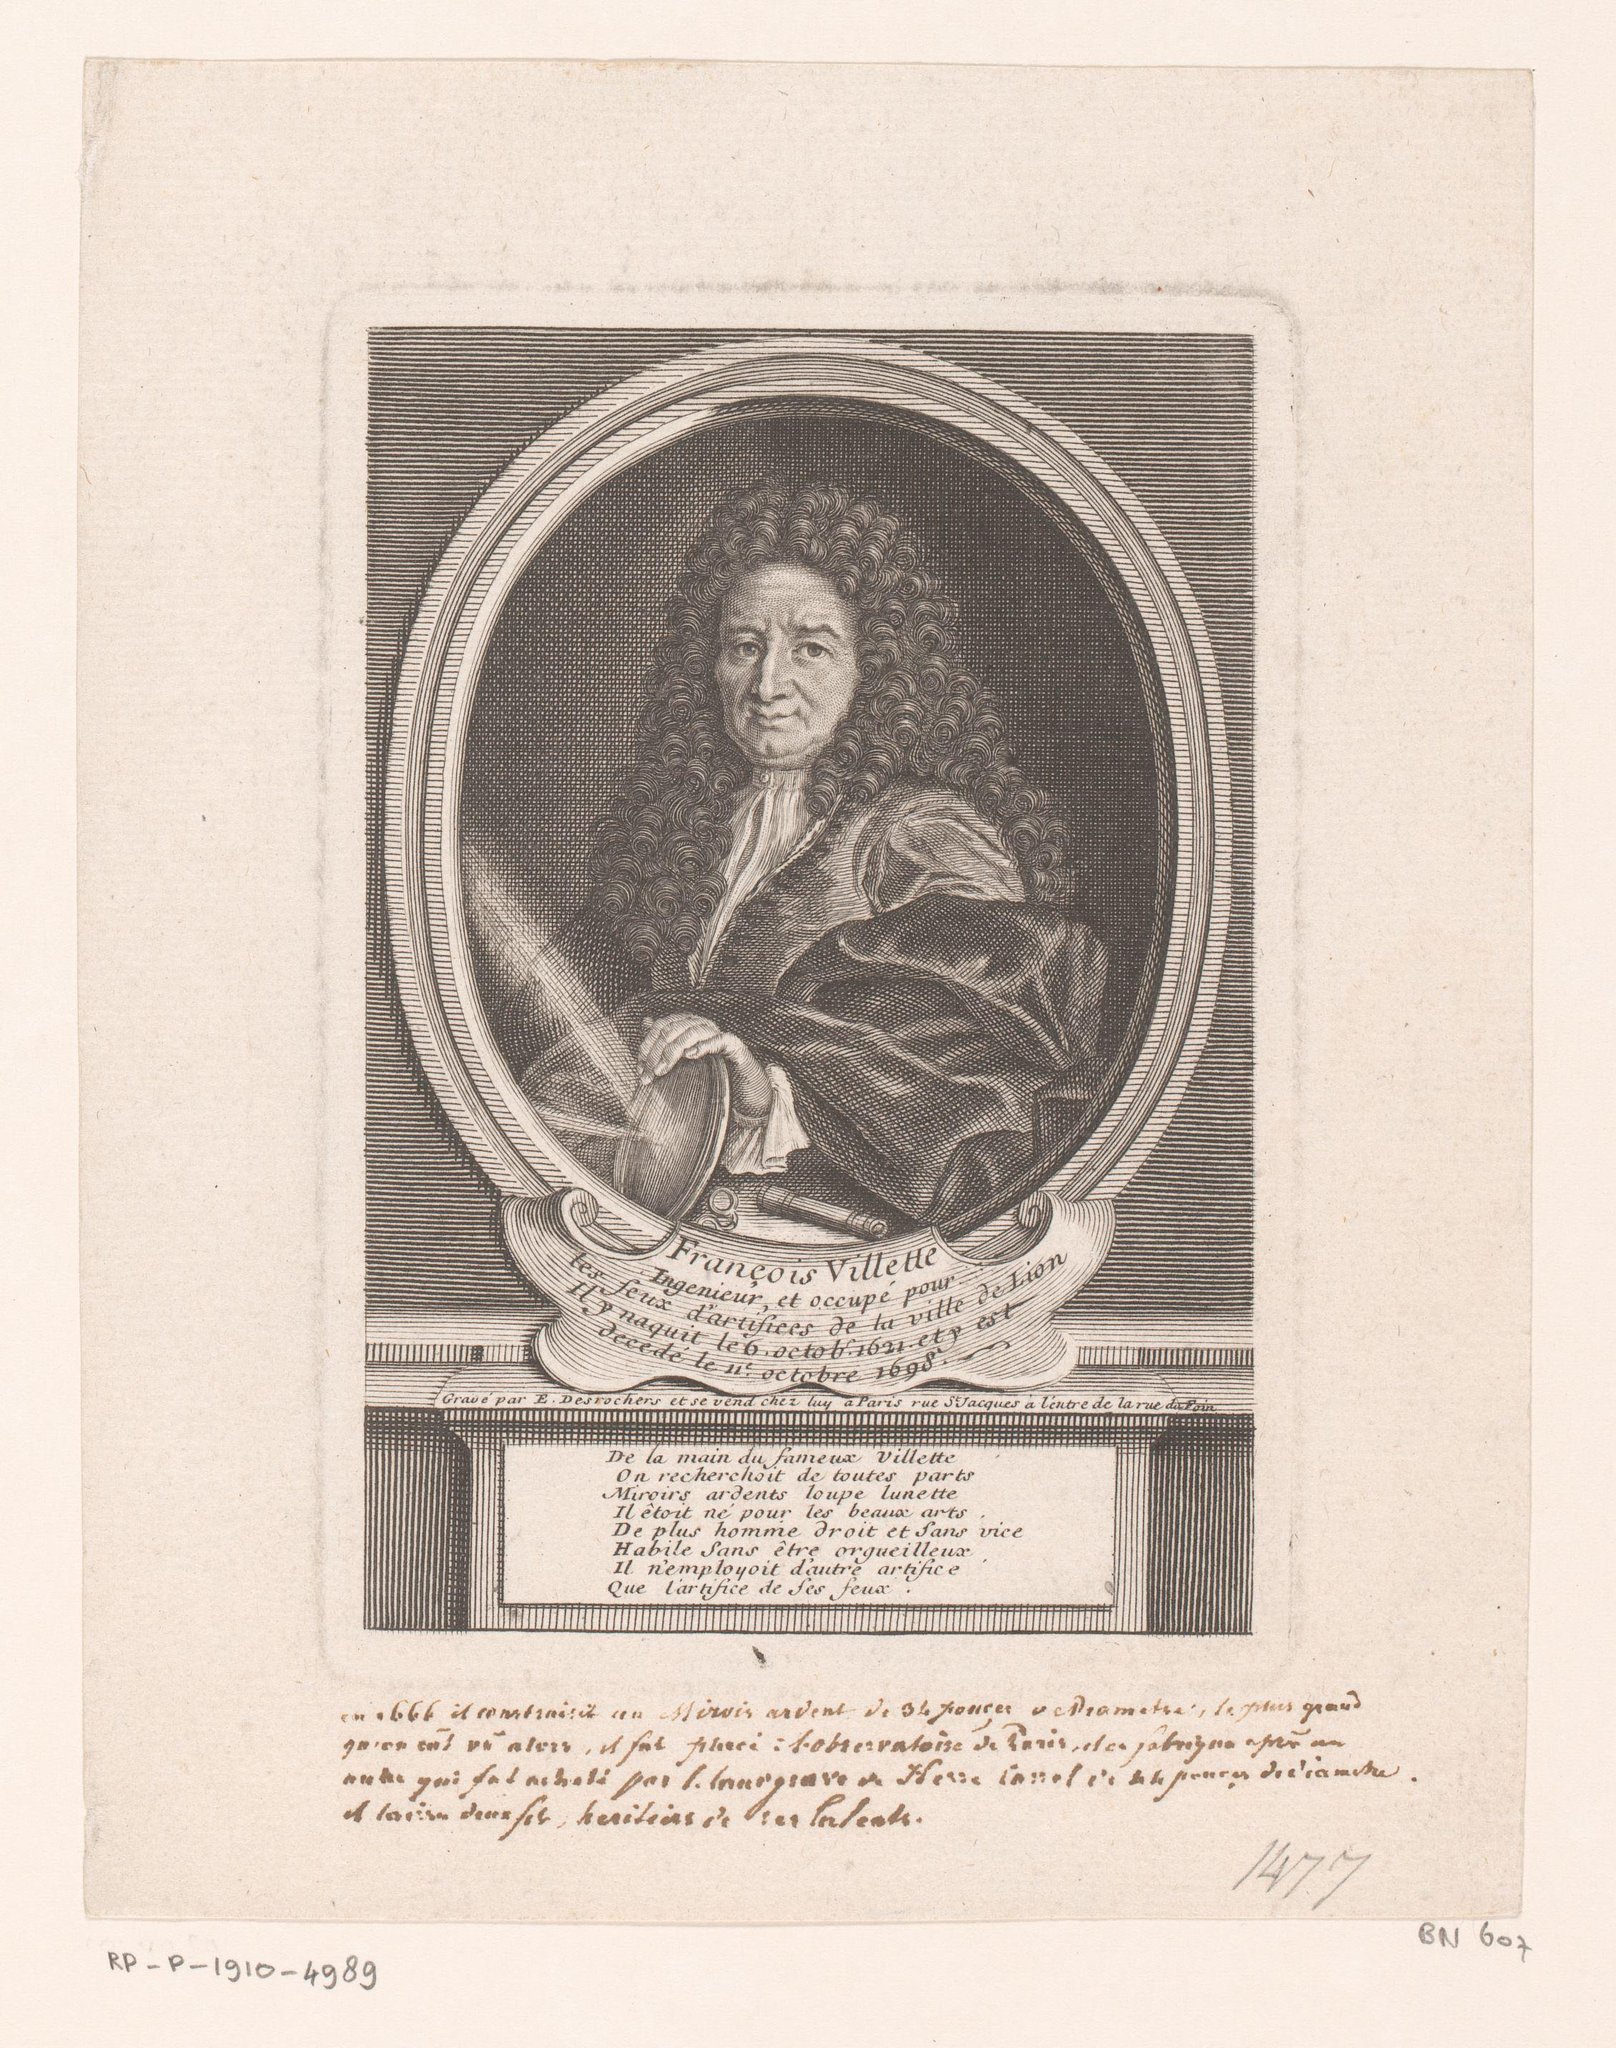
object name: print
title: Recueil de portraits (...)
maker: étienne desrochers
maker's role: print maker, publisher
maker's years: 1668-1741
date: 1726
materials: paper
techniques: engraving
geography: paris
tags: engineer, historical persons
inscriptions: inscription, collector's mark: Lugt 2228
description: Behoort waarschijnlijk tot een serie portretten, grotendeels door Etienne Desrochers, getiteld: 'Recueil de portraits de personnes qui se sont distinguées tant dans les Armes que dans Belles-Lettres et les Arts, comme aussi la famille royale de France et autres cours étrangères'. De serie werd initieel uitgegeven door Desrochers en aangekondigd in 'Mercure' in mei 1726, p. 985. Echter was Desrochers reeds enkele jaren eerder begonnen met het uitgeven van de serie. Na de dood van Desrochers werd de serie voortgezet door Gilles Edme Petit. Een latere staat werd uitgegeven door Jean François Daumont in Parijs.